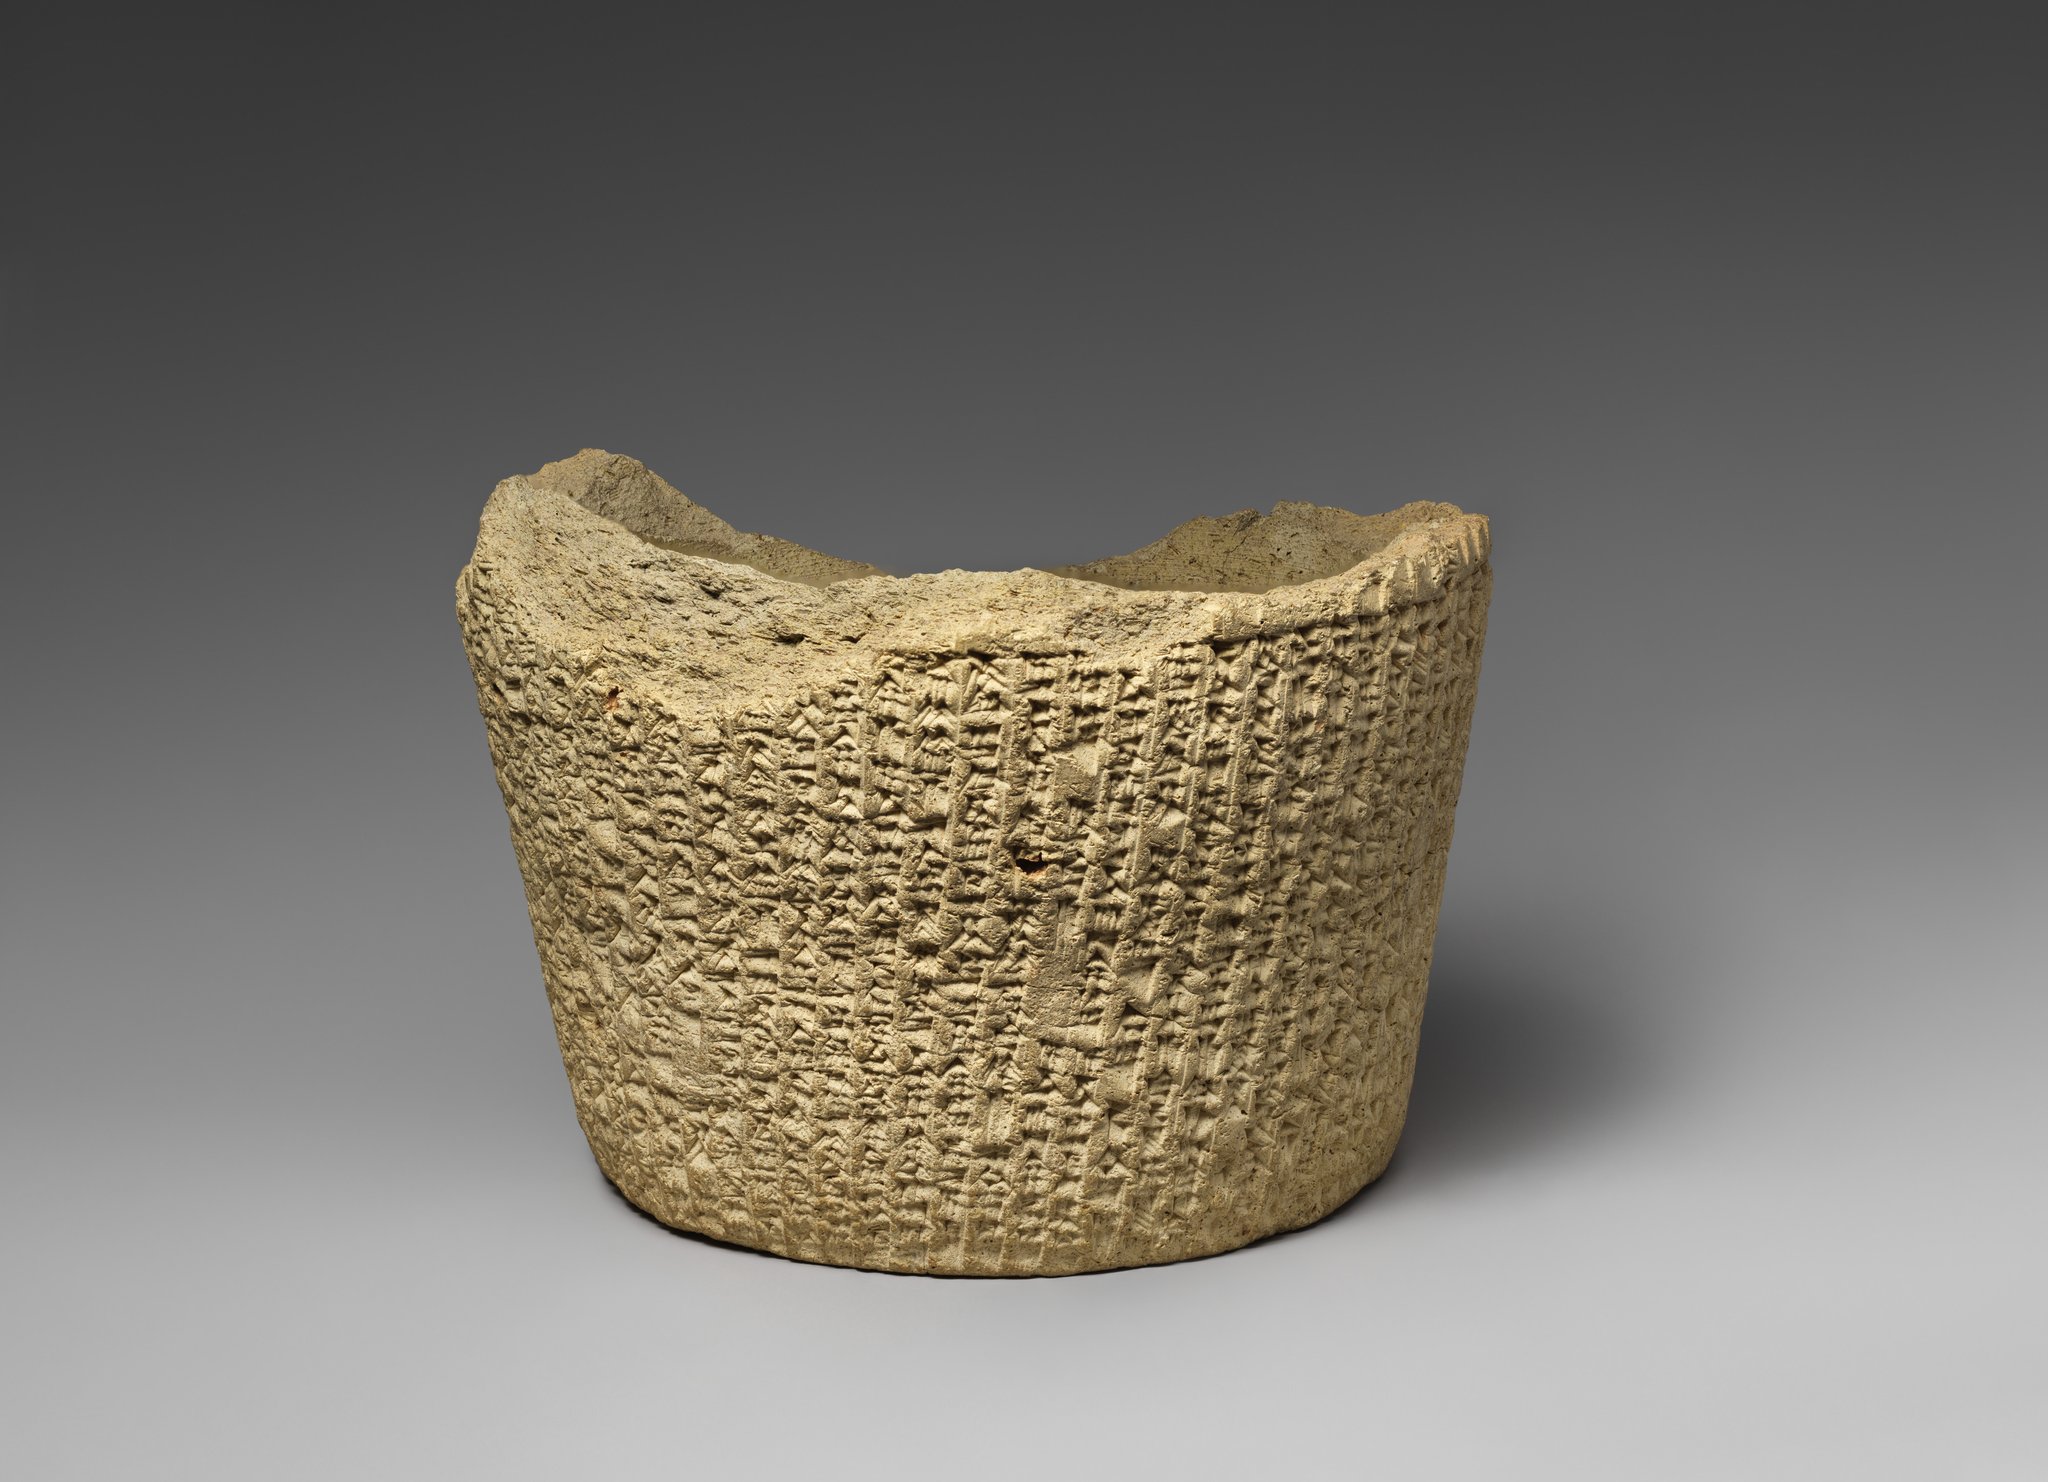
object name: cuneiform cylinder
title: Cuneiform cylinder: Ehulhul inscription of Nabonidus describing his work on three temples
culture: babylonian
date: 555-539 BCE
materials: clay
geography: mesopotamia